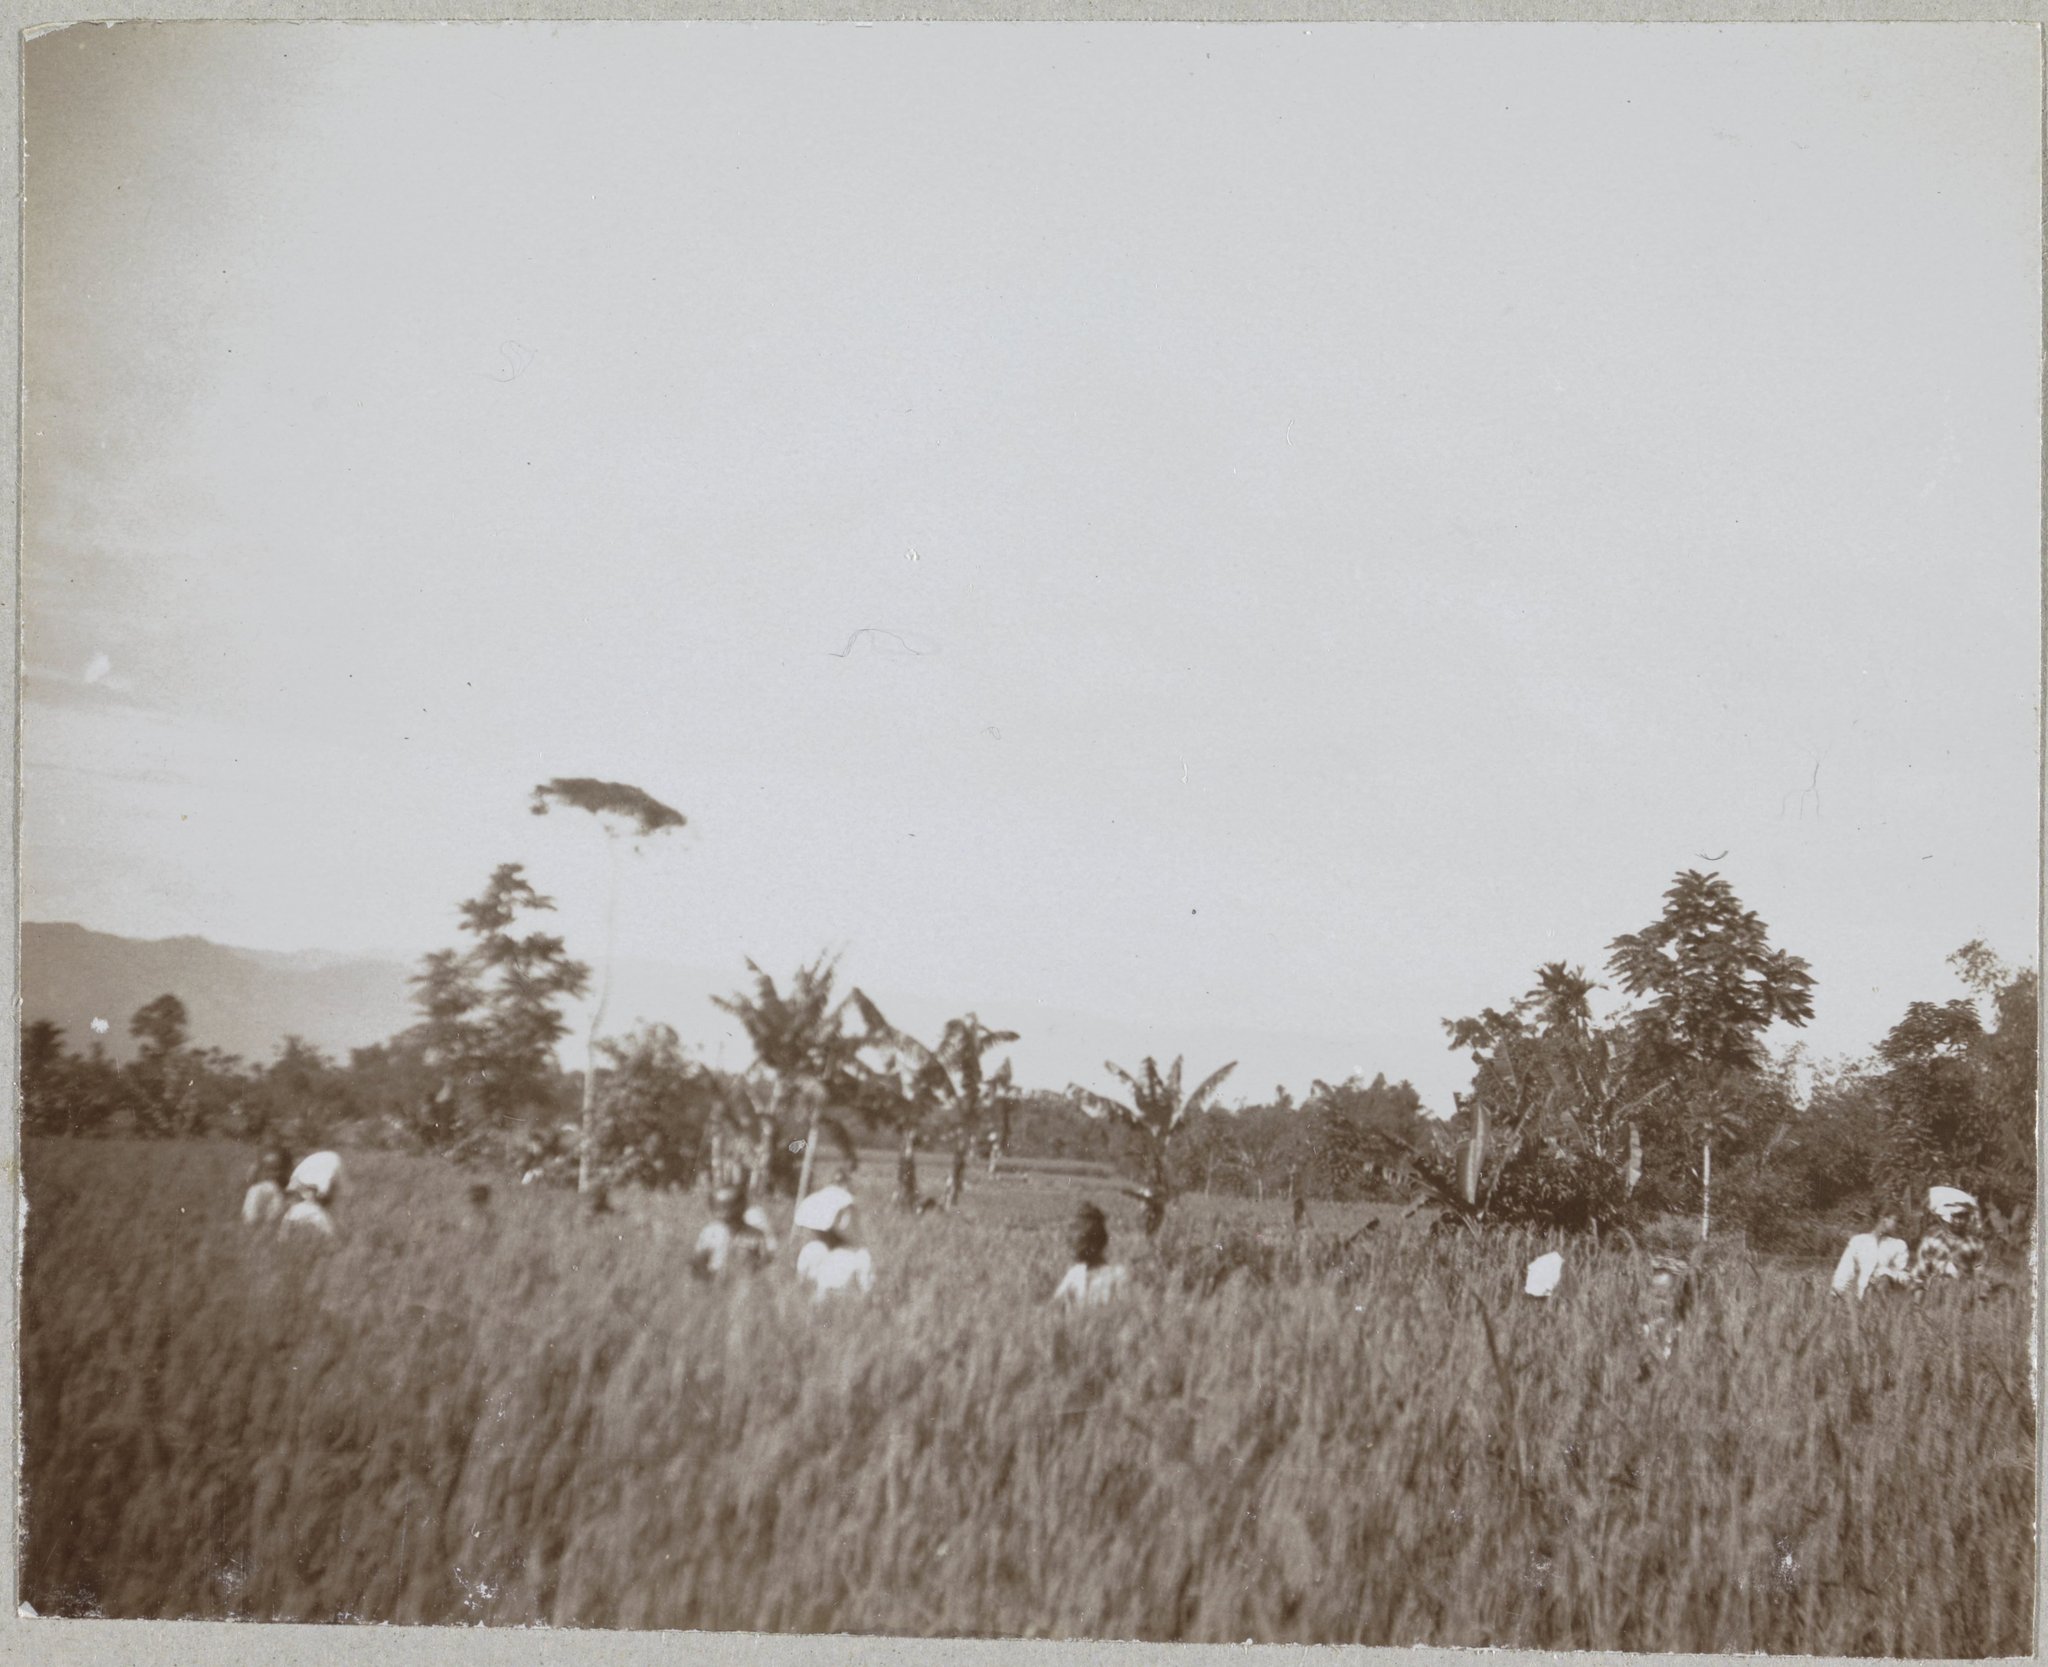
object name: photograph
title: Paddisnijders in veld, Nederlands-Indië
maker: Anonymous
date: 1895-1915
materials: cardboard, paper, photographic support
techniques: collodion silver print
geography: dutch east indies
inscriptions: annotation: ‘4) Paddisnijders.’